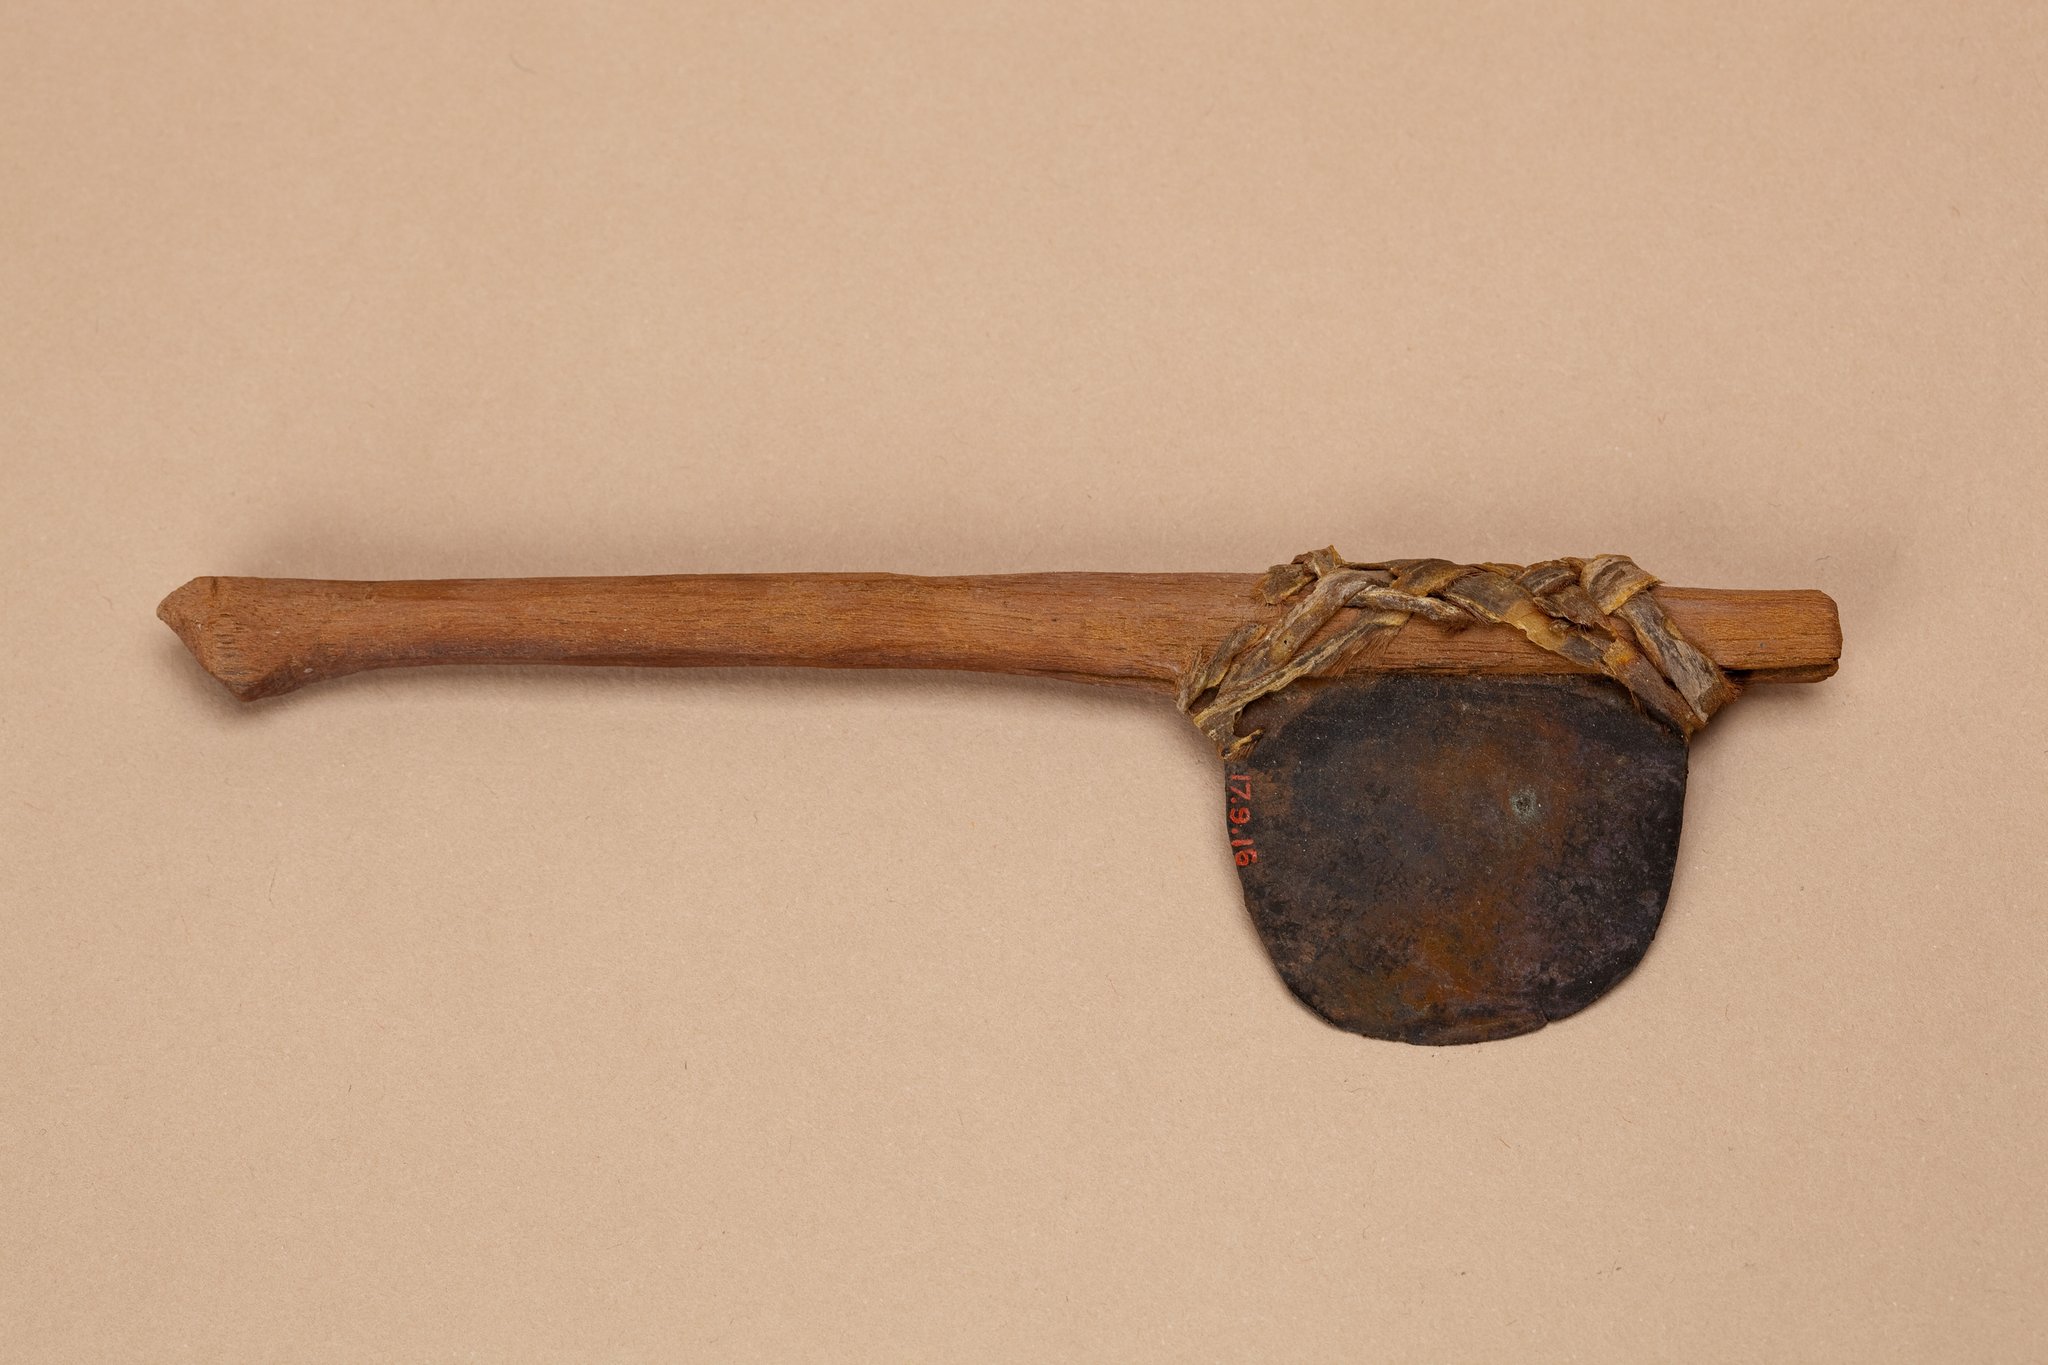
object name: model ax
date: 1981-1802 BCE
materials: copper, wood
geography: egypt